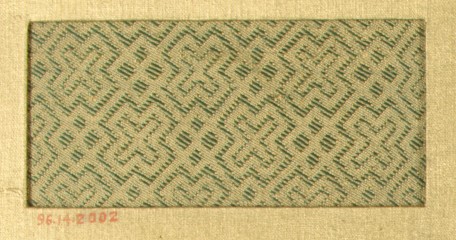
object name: piece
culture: japanese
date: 1701-1900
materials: silk